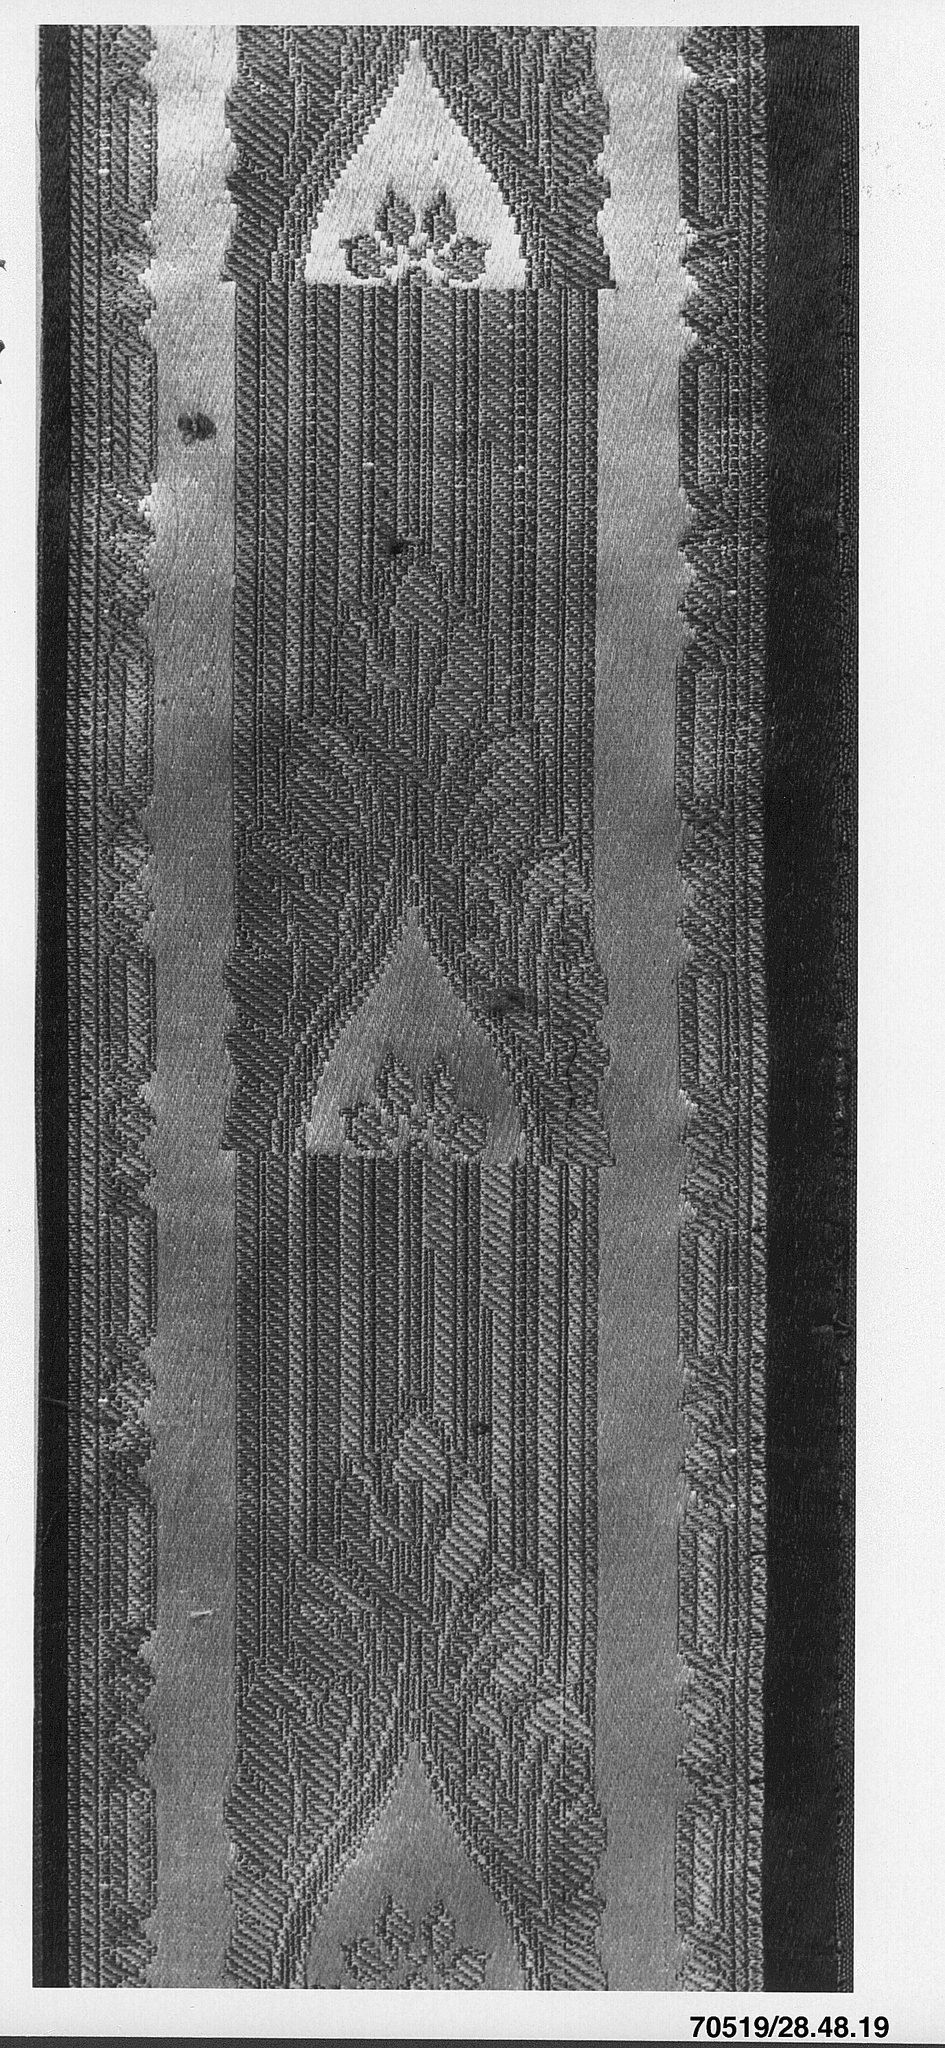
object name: border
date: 1801-1900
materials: silk